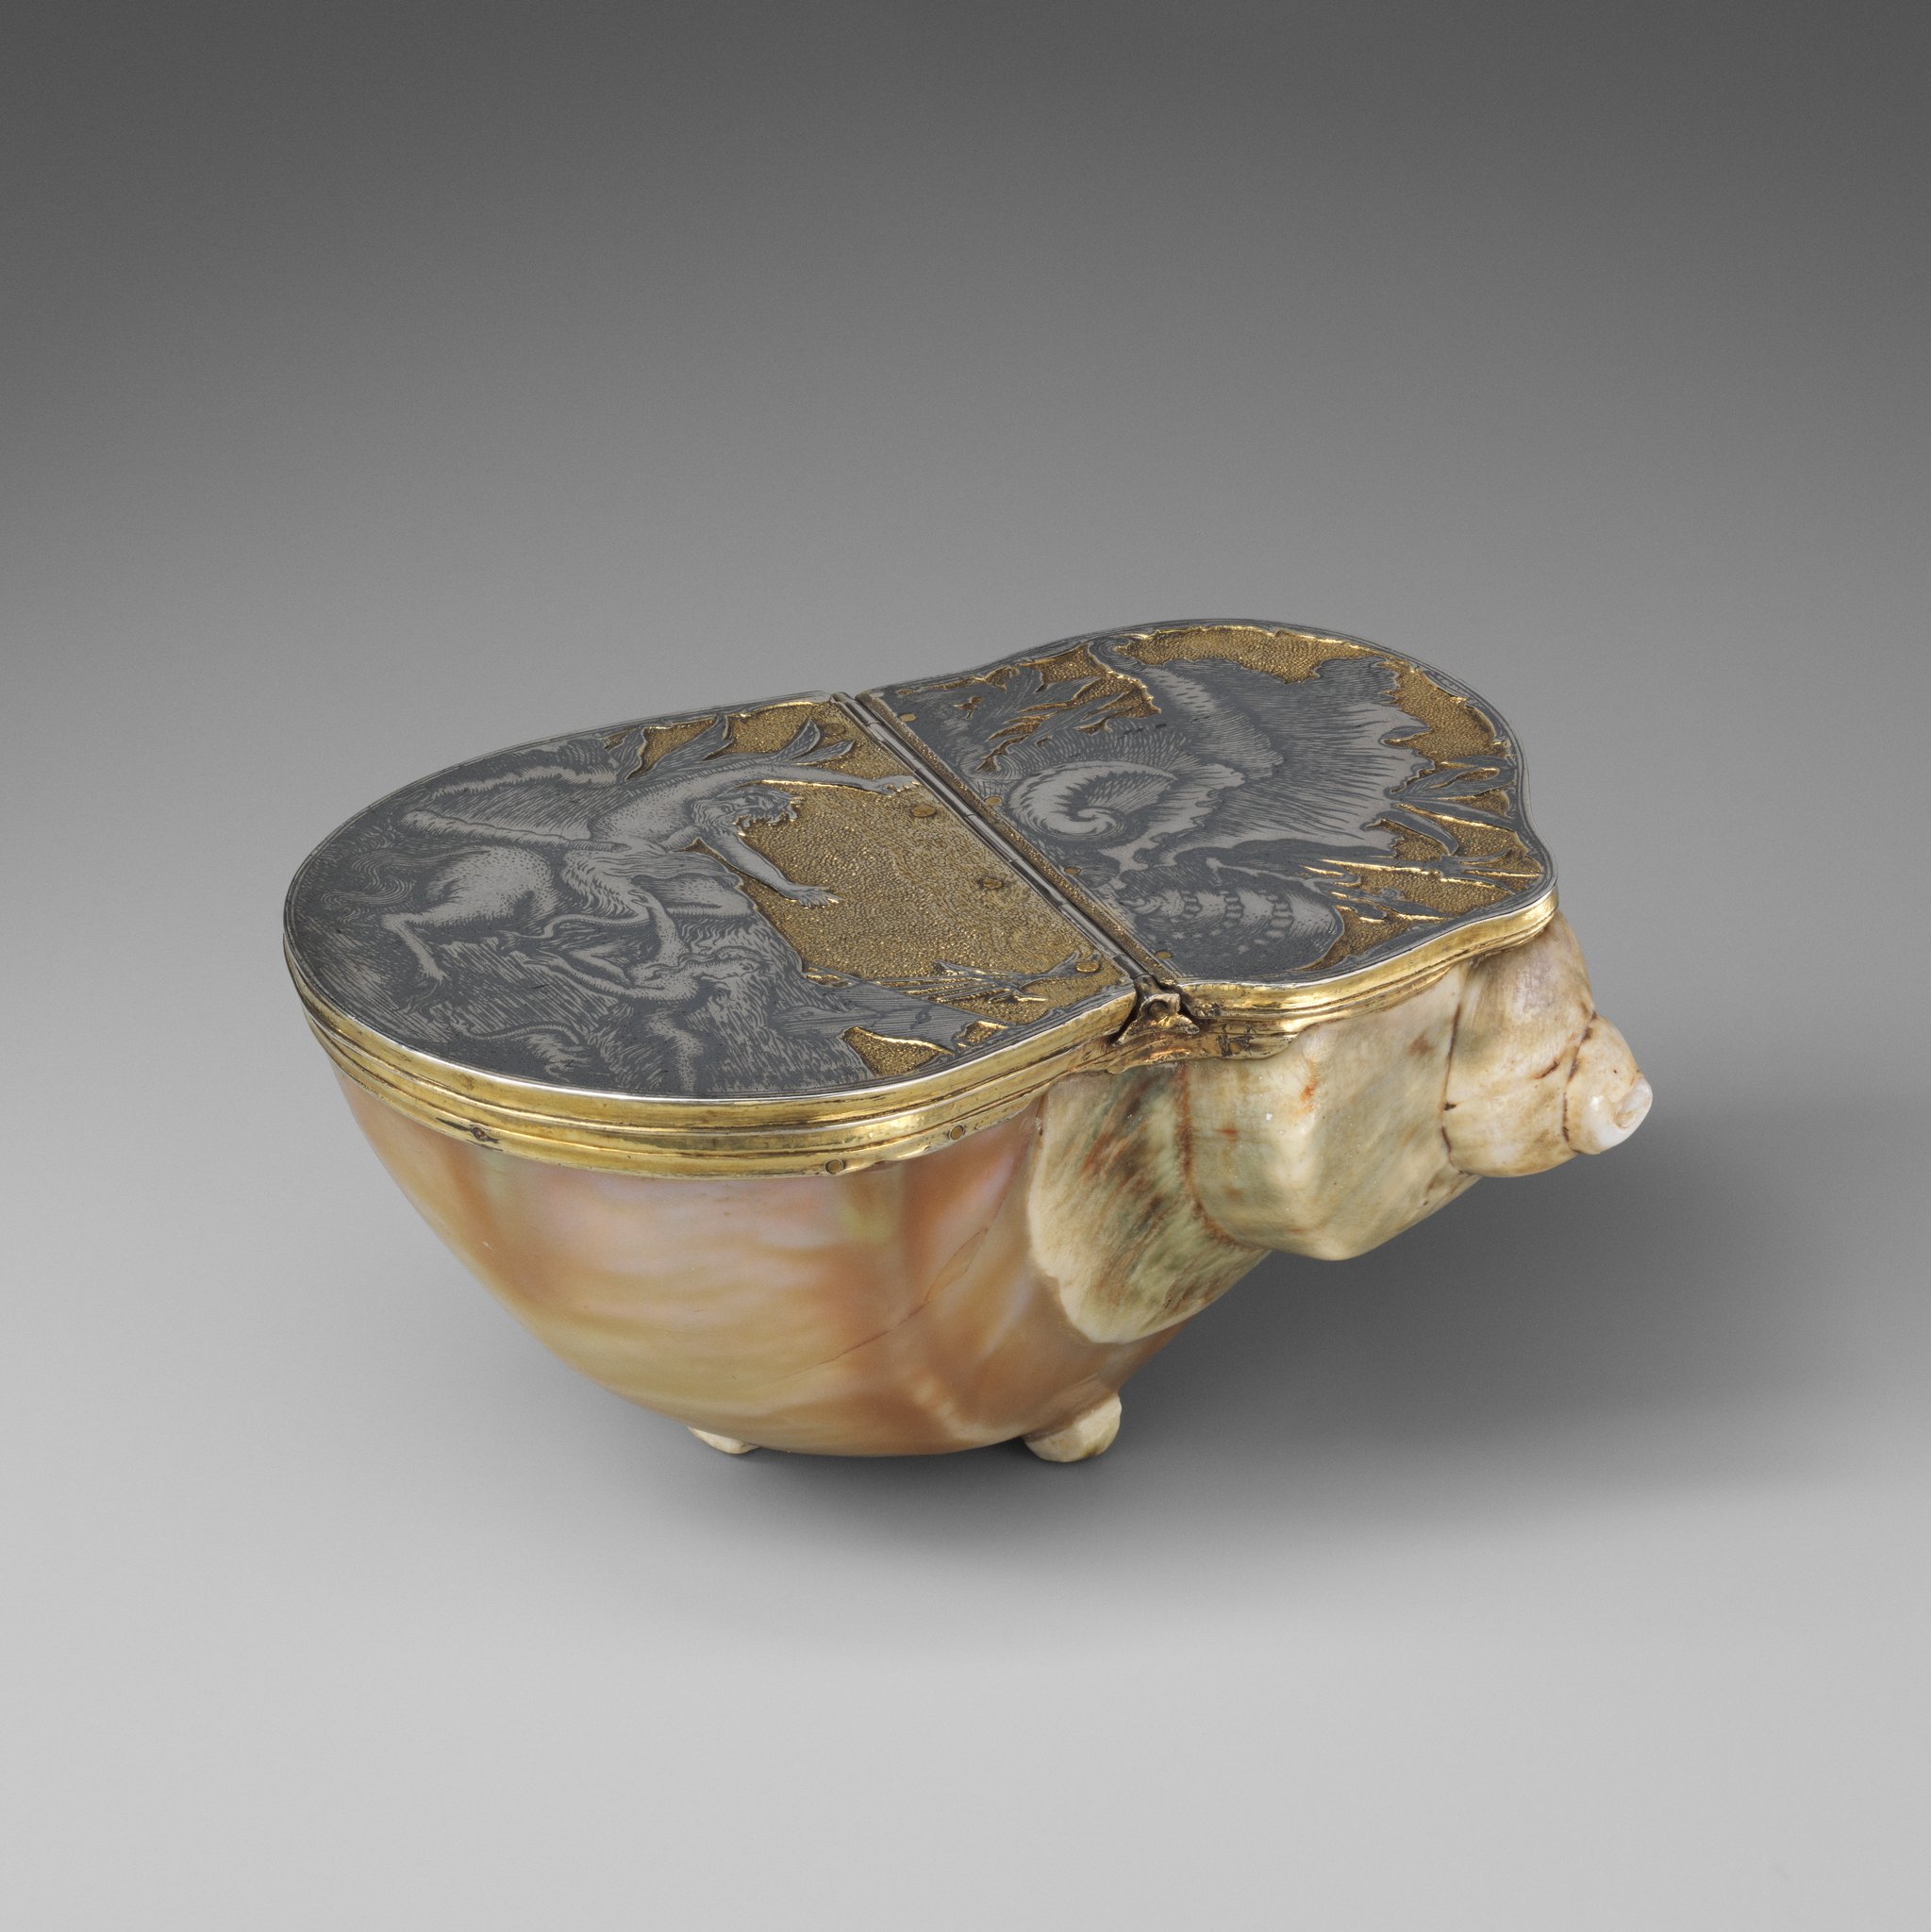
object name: table snuffbox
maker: jacques de lajoüe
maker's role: artist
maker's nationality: french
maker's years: 1686-1761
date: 1745-1750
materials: niello, shell, silver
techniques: engraving, gilding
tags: triton